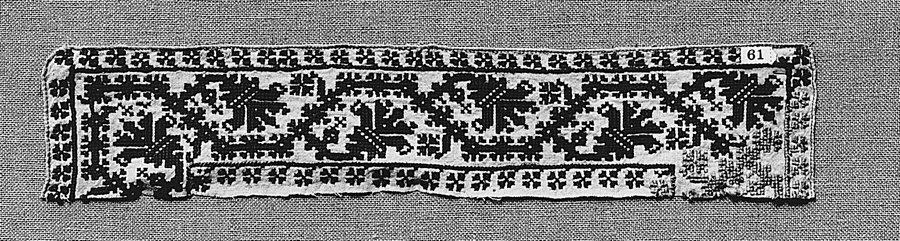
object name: band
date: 1701-1800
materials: linen, silk